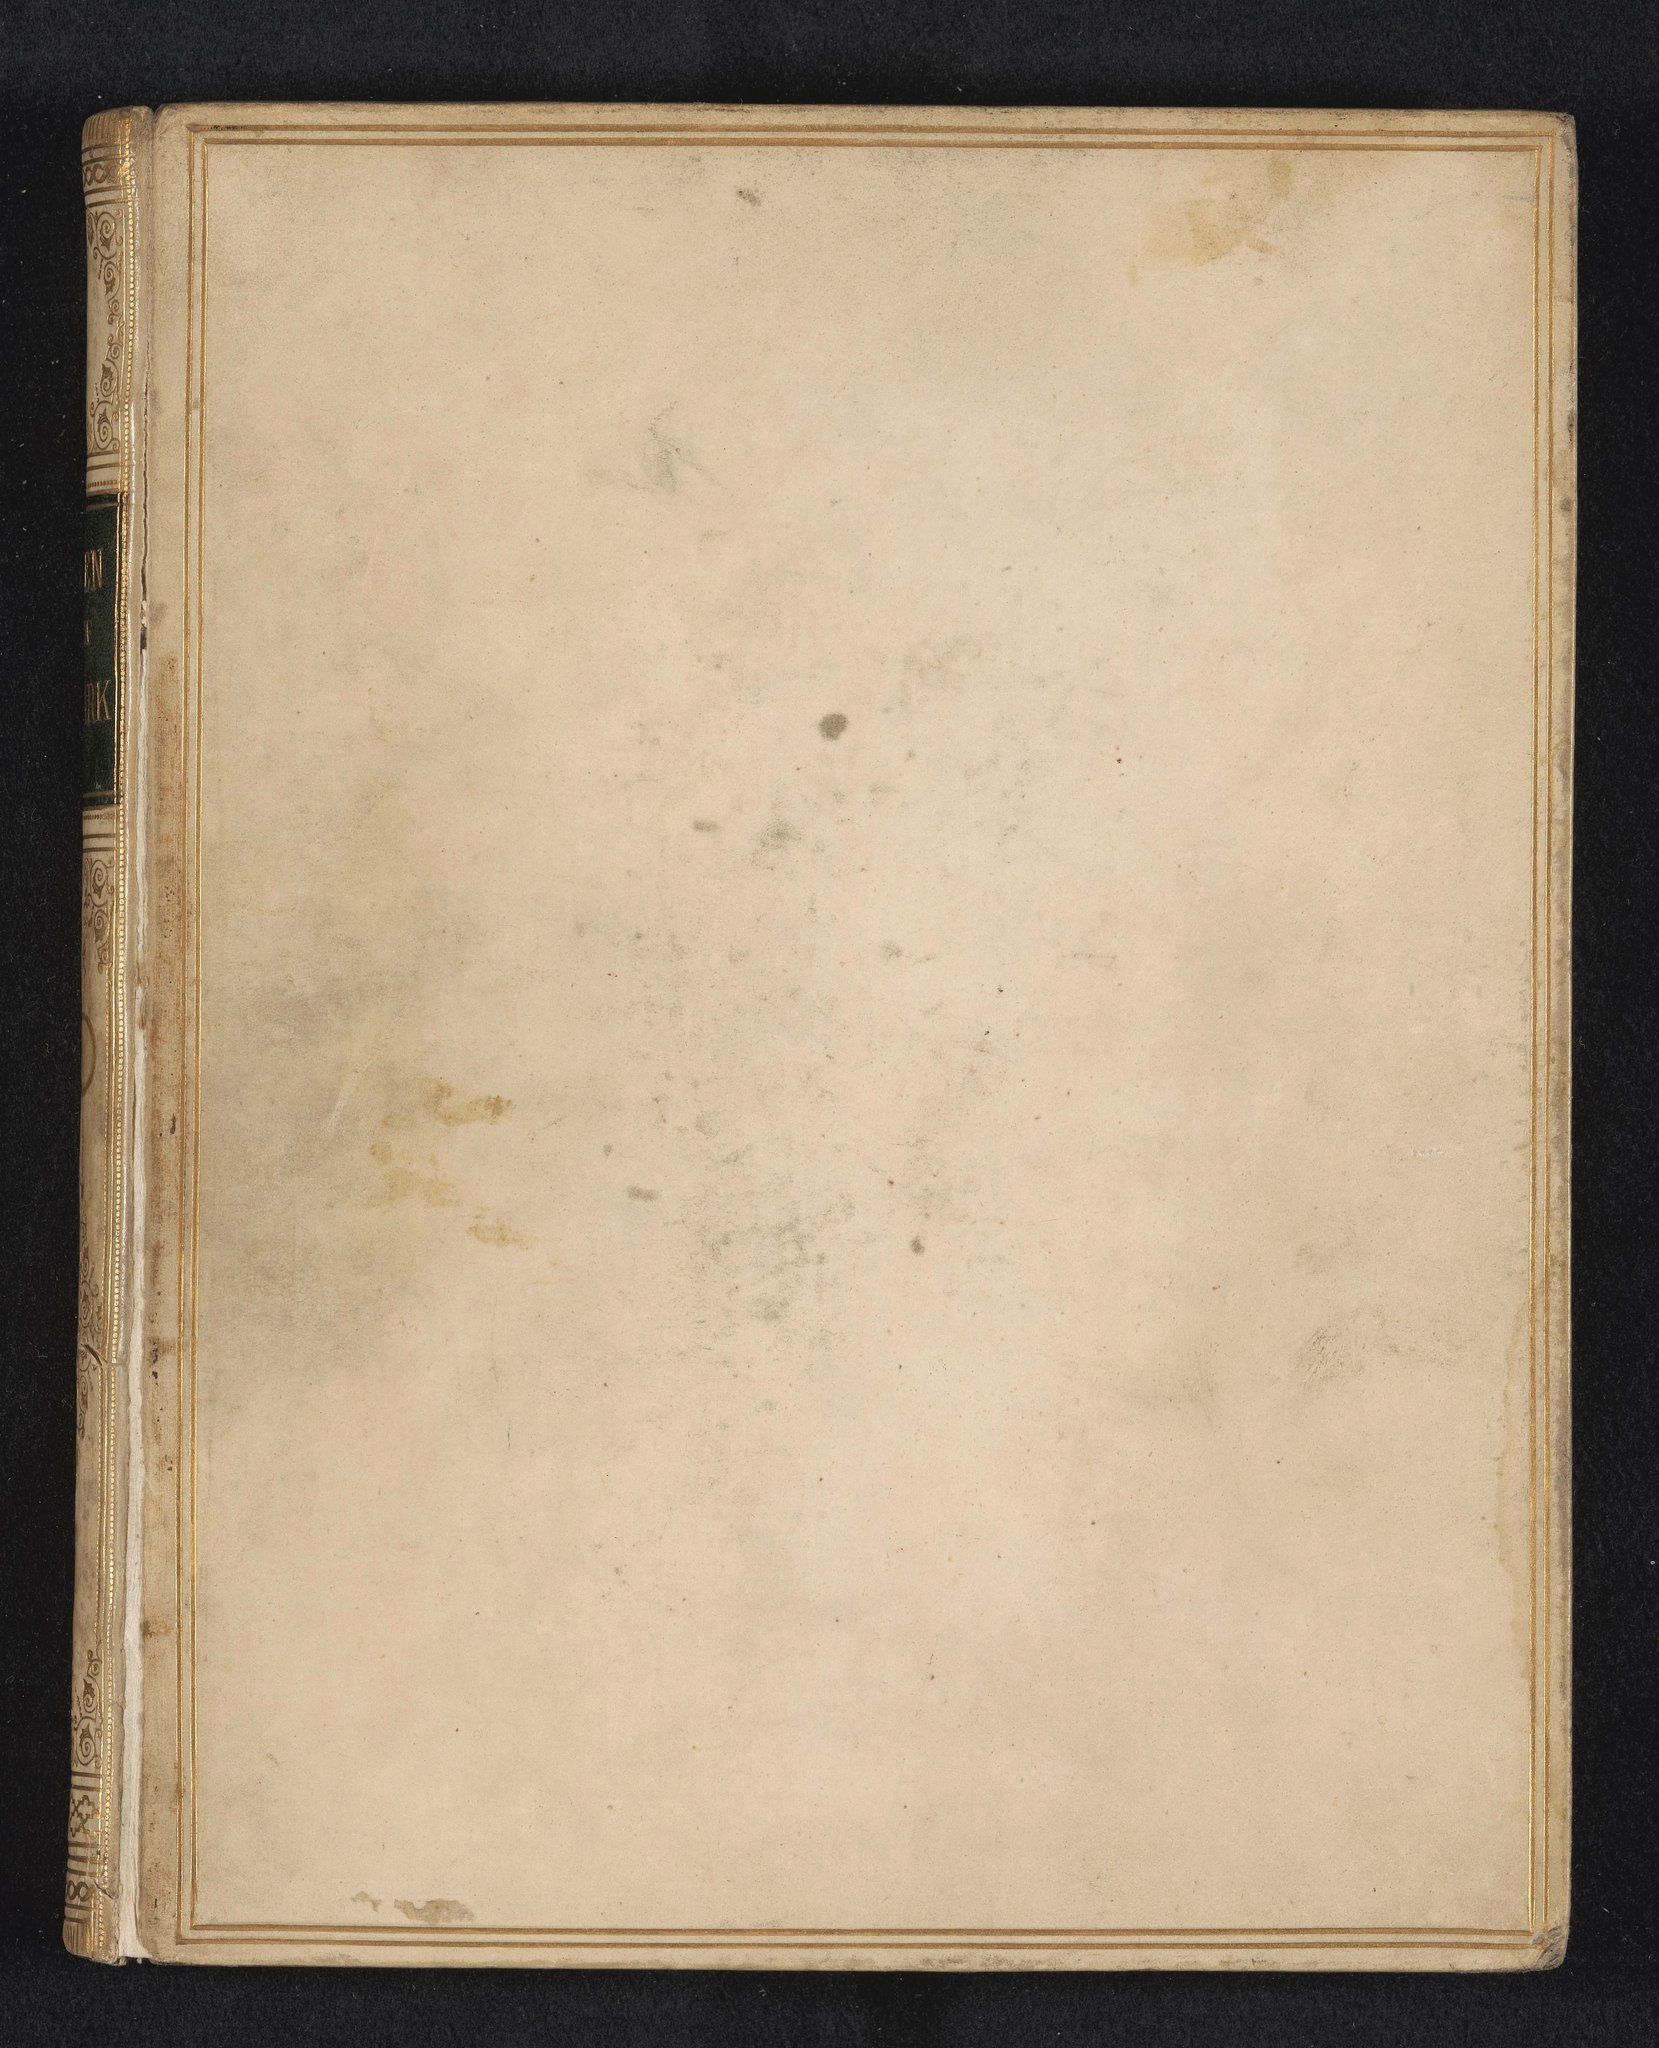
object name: book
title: Men of mark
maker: thompson cooper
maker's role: schrijver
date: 1876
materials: cardboard, linen, paper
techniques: printing, woodburytype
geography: london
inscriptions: inscription, inscription: ‘Booksellers stationers Greene's Library 16 cl[...]’